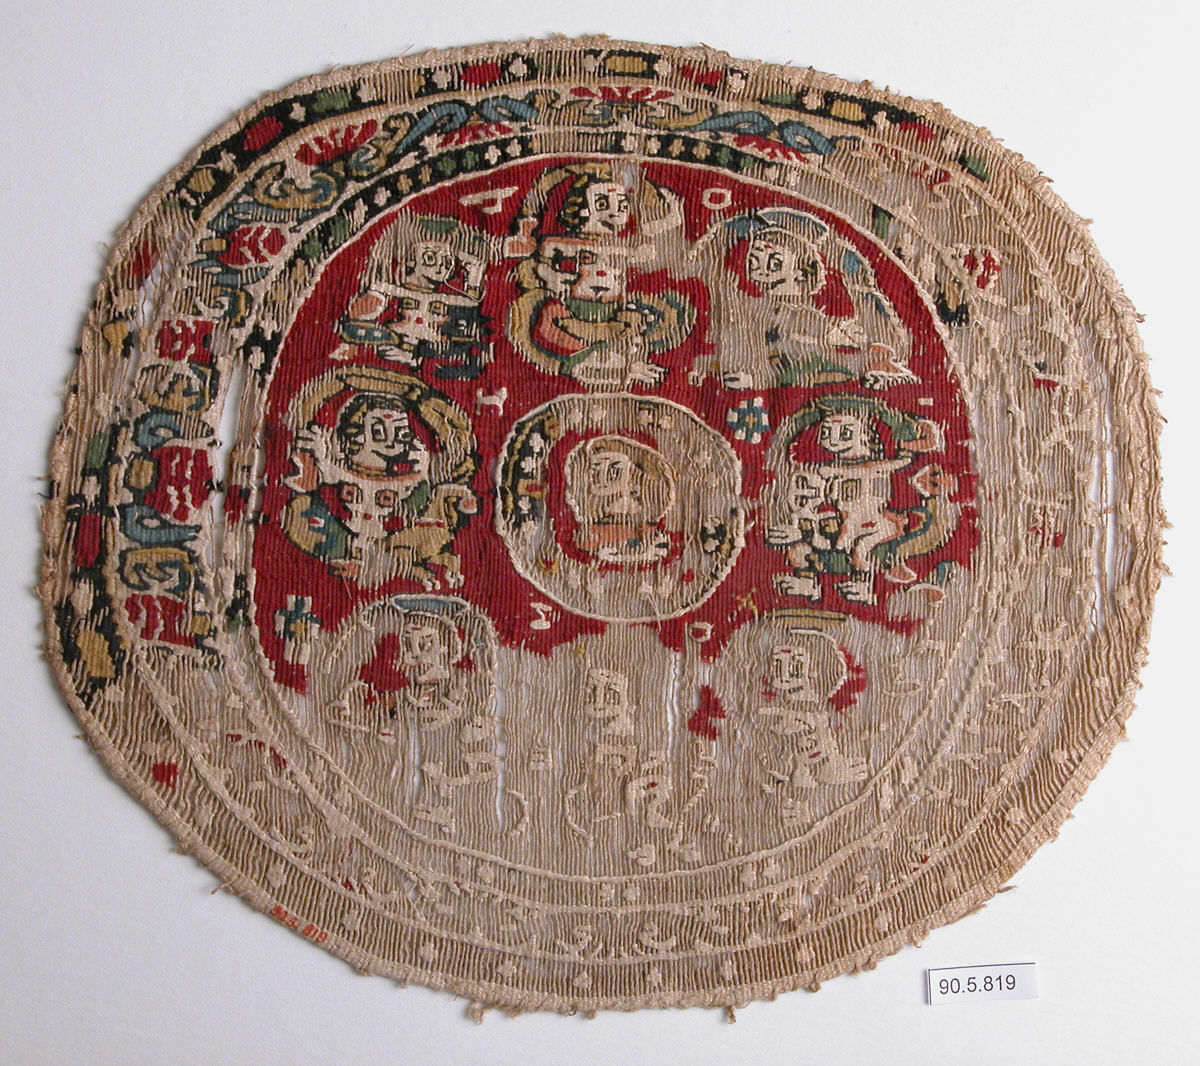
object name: textile fragment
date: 501-600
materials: linen, wool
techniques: weave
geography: egypt